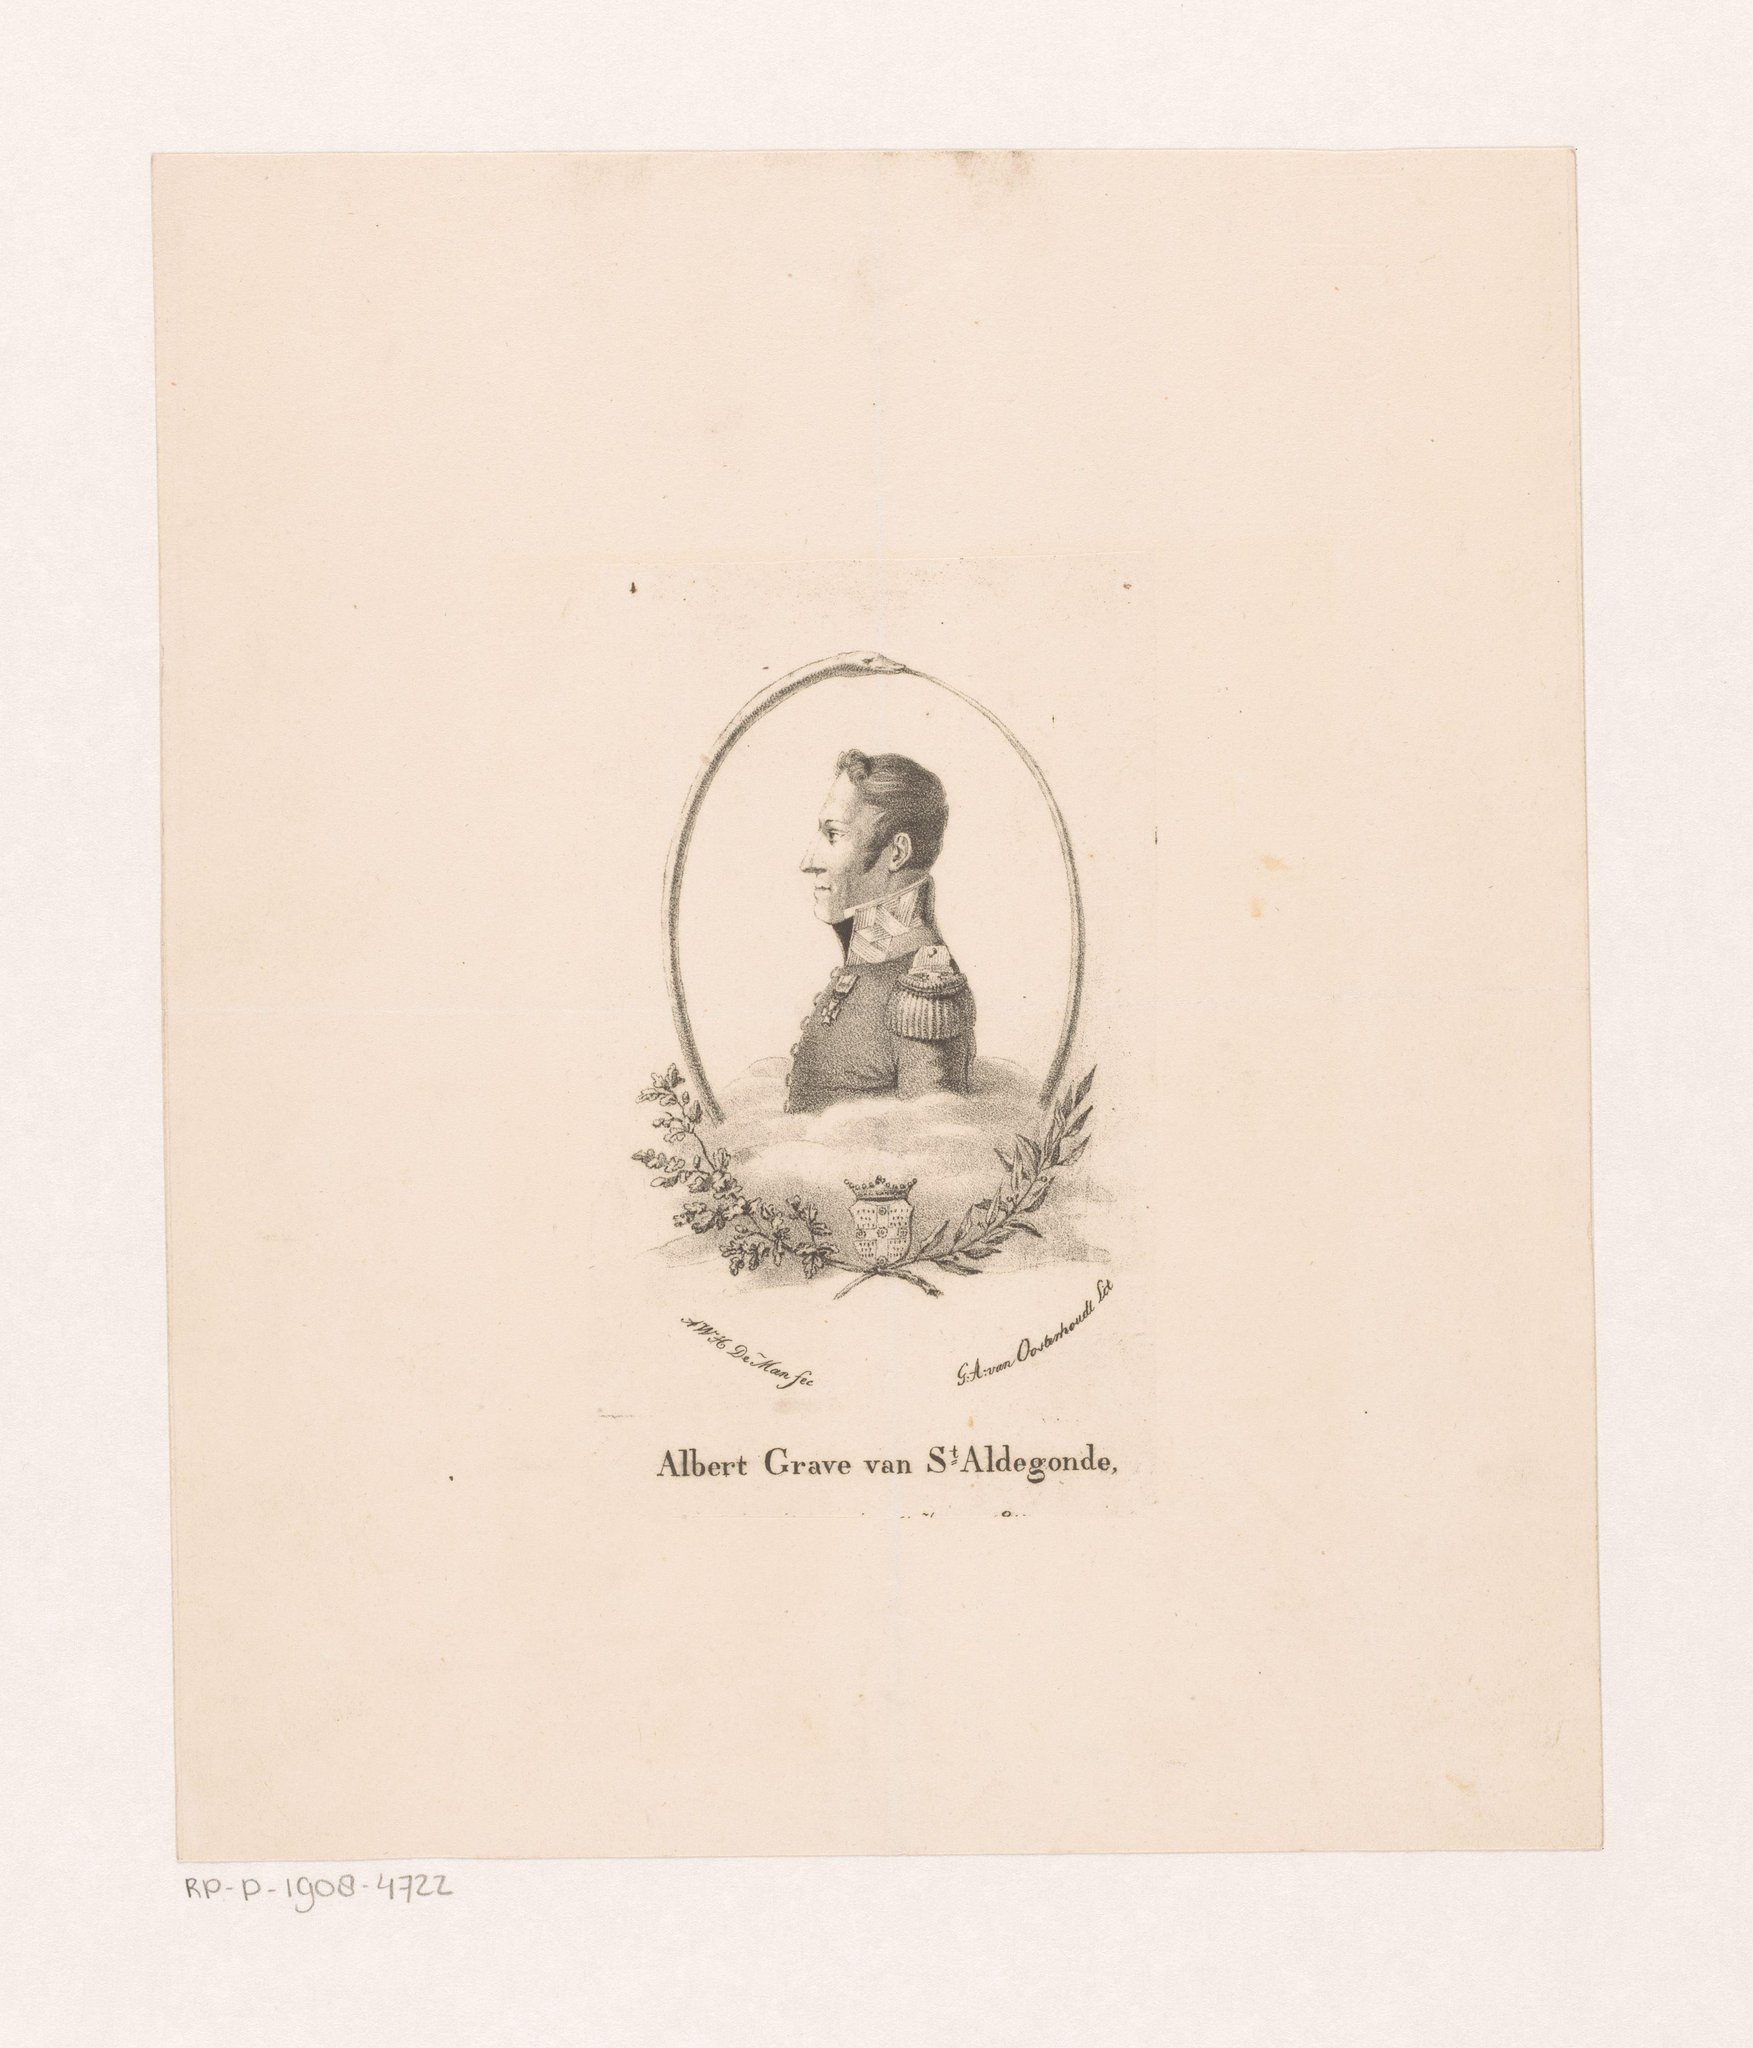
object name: print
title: Albert Grave van St Aldegonde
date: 1817-1834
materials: paper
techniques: lithograph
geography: netherlands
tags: historical persons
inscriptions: watermark, collector's mark: Lugt 2228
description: Deel opschrift ontbreekt door afsnijding chine collé. Oorspronkelijk opschrift vermeld: Albart grave van St Aldegonde / Overleden den 7 Juny 1817.